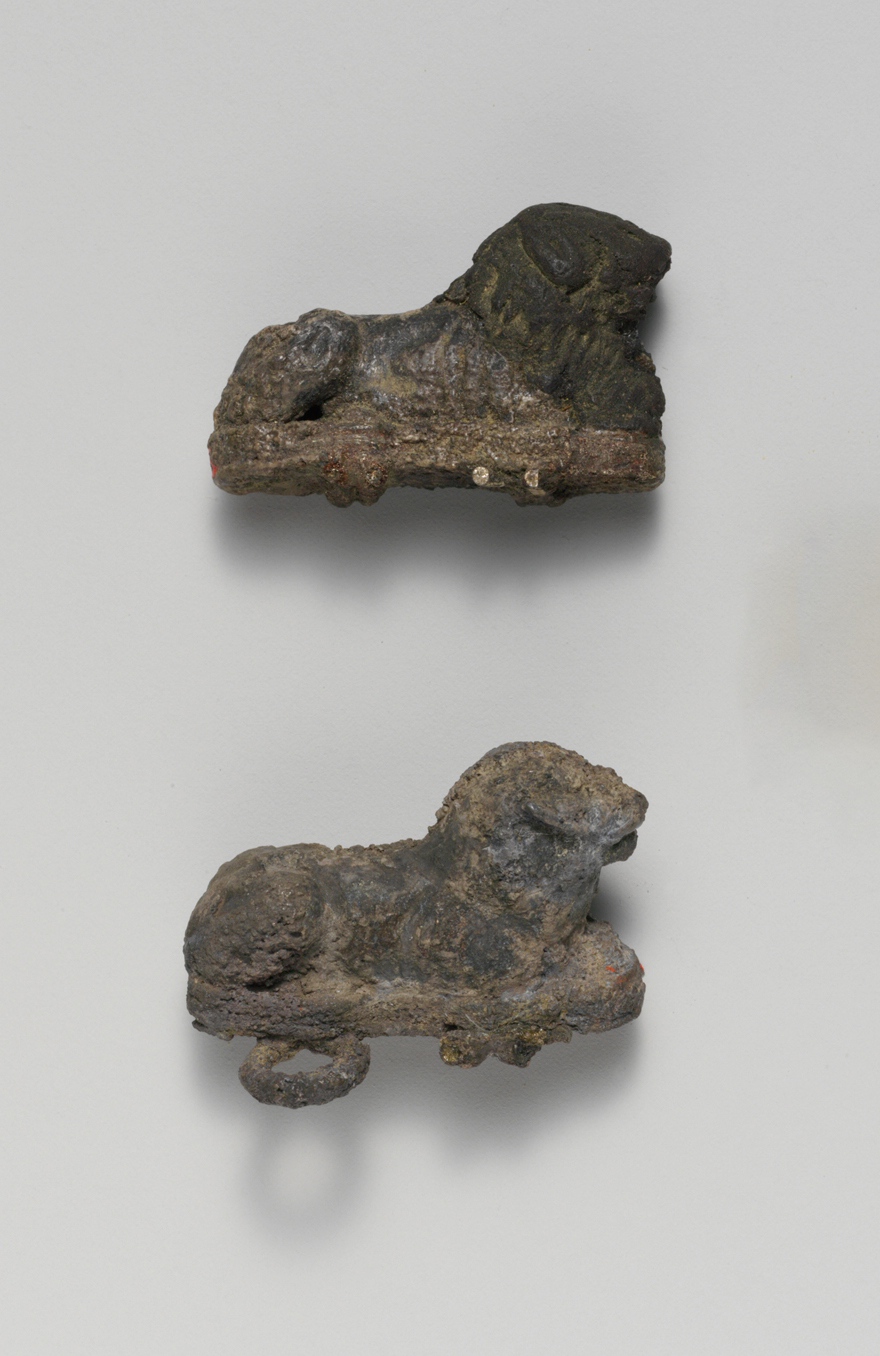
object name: clasp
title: Two silver clasps with lions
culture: etruscan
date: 500-401 BCE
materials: silver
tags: lions